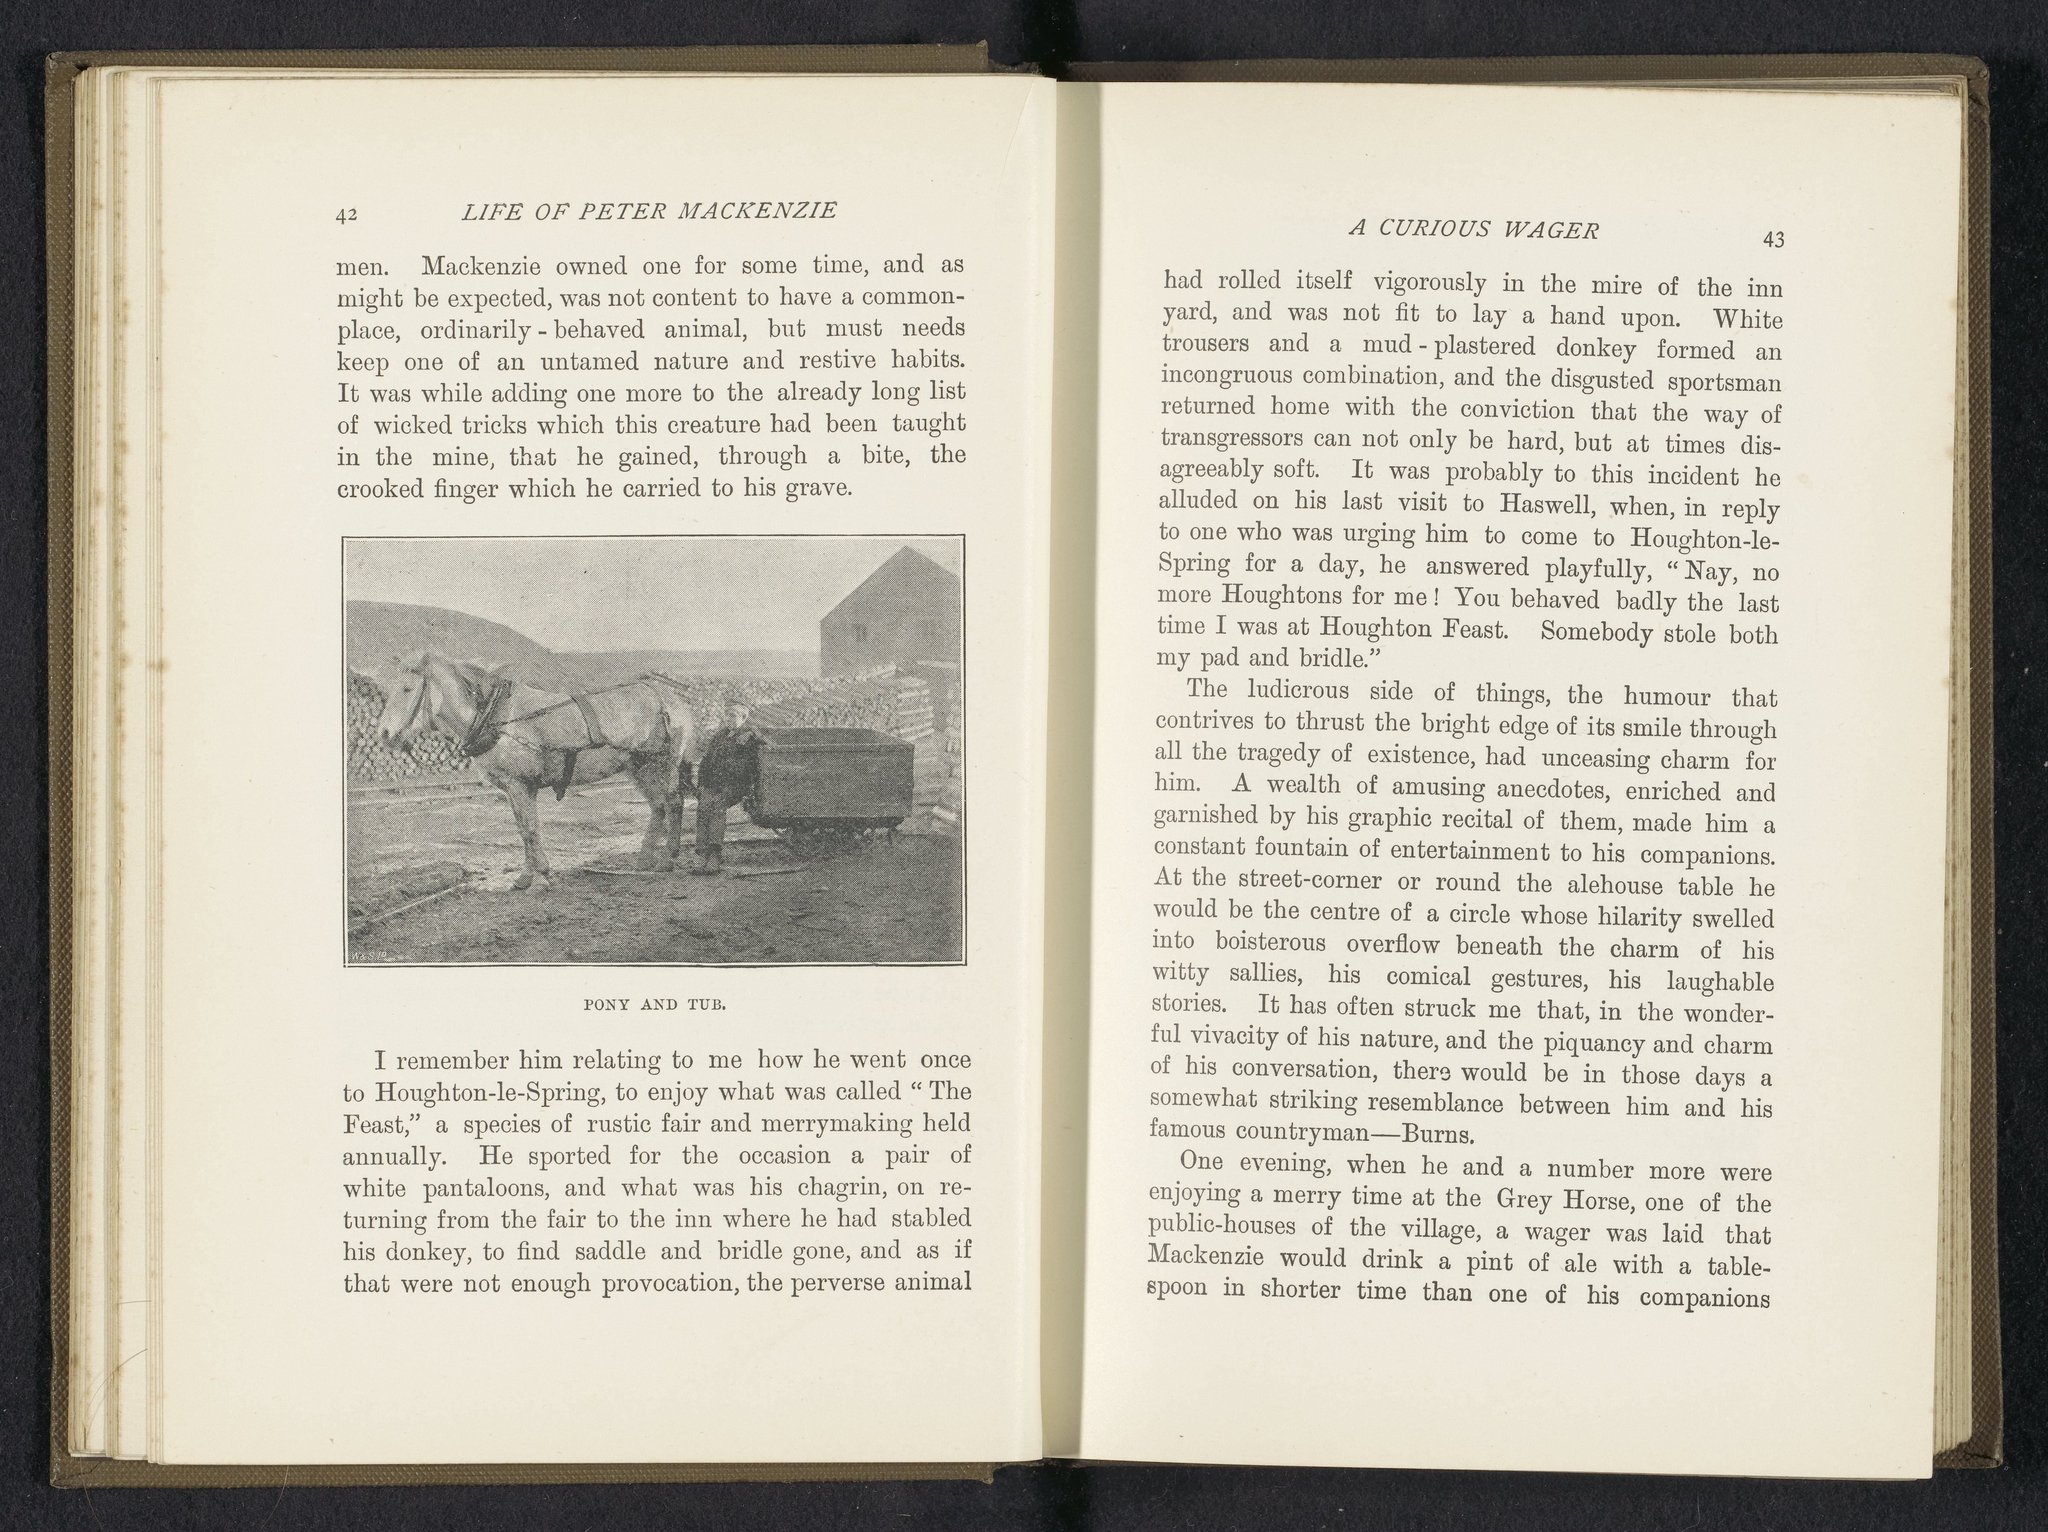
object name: photomechanical print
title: Pony and tub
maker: Anonymous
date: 1887-1897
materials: paper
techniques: autotype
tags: horse, (farm) wagon, freight wagon, cart